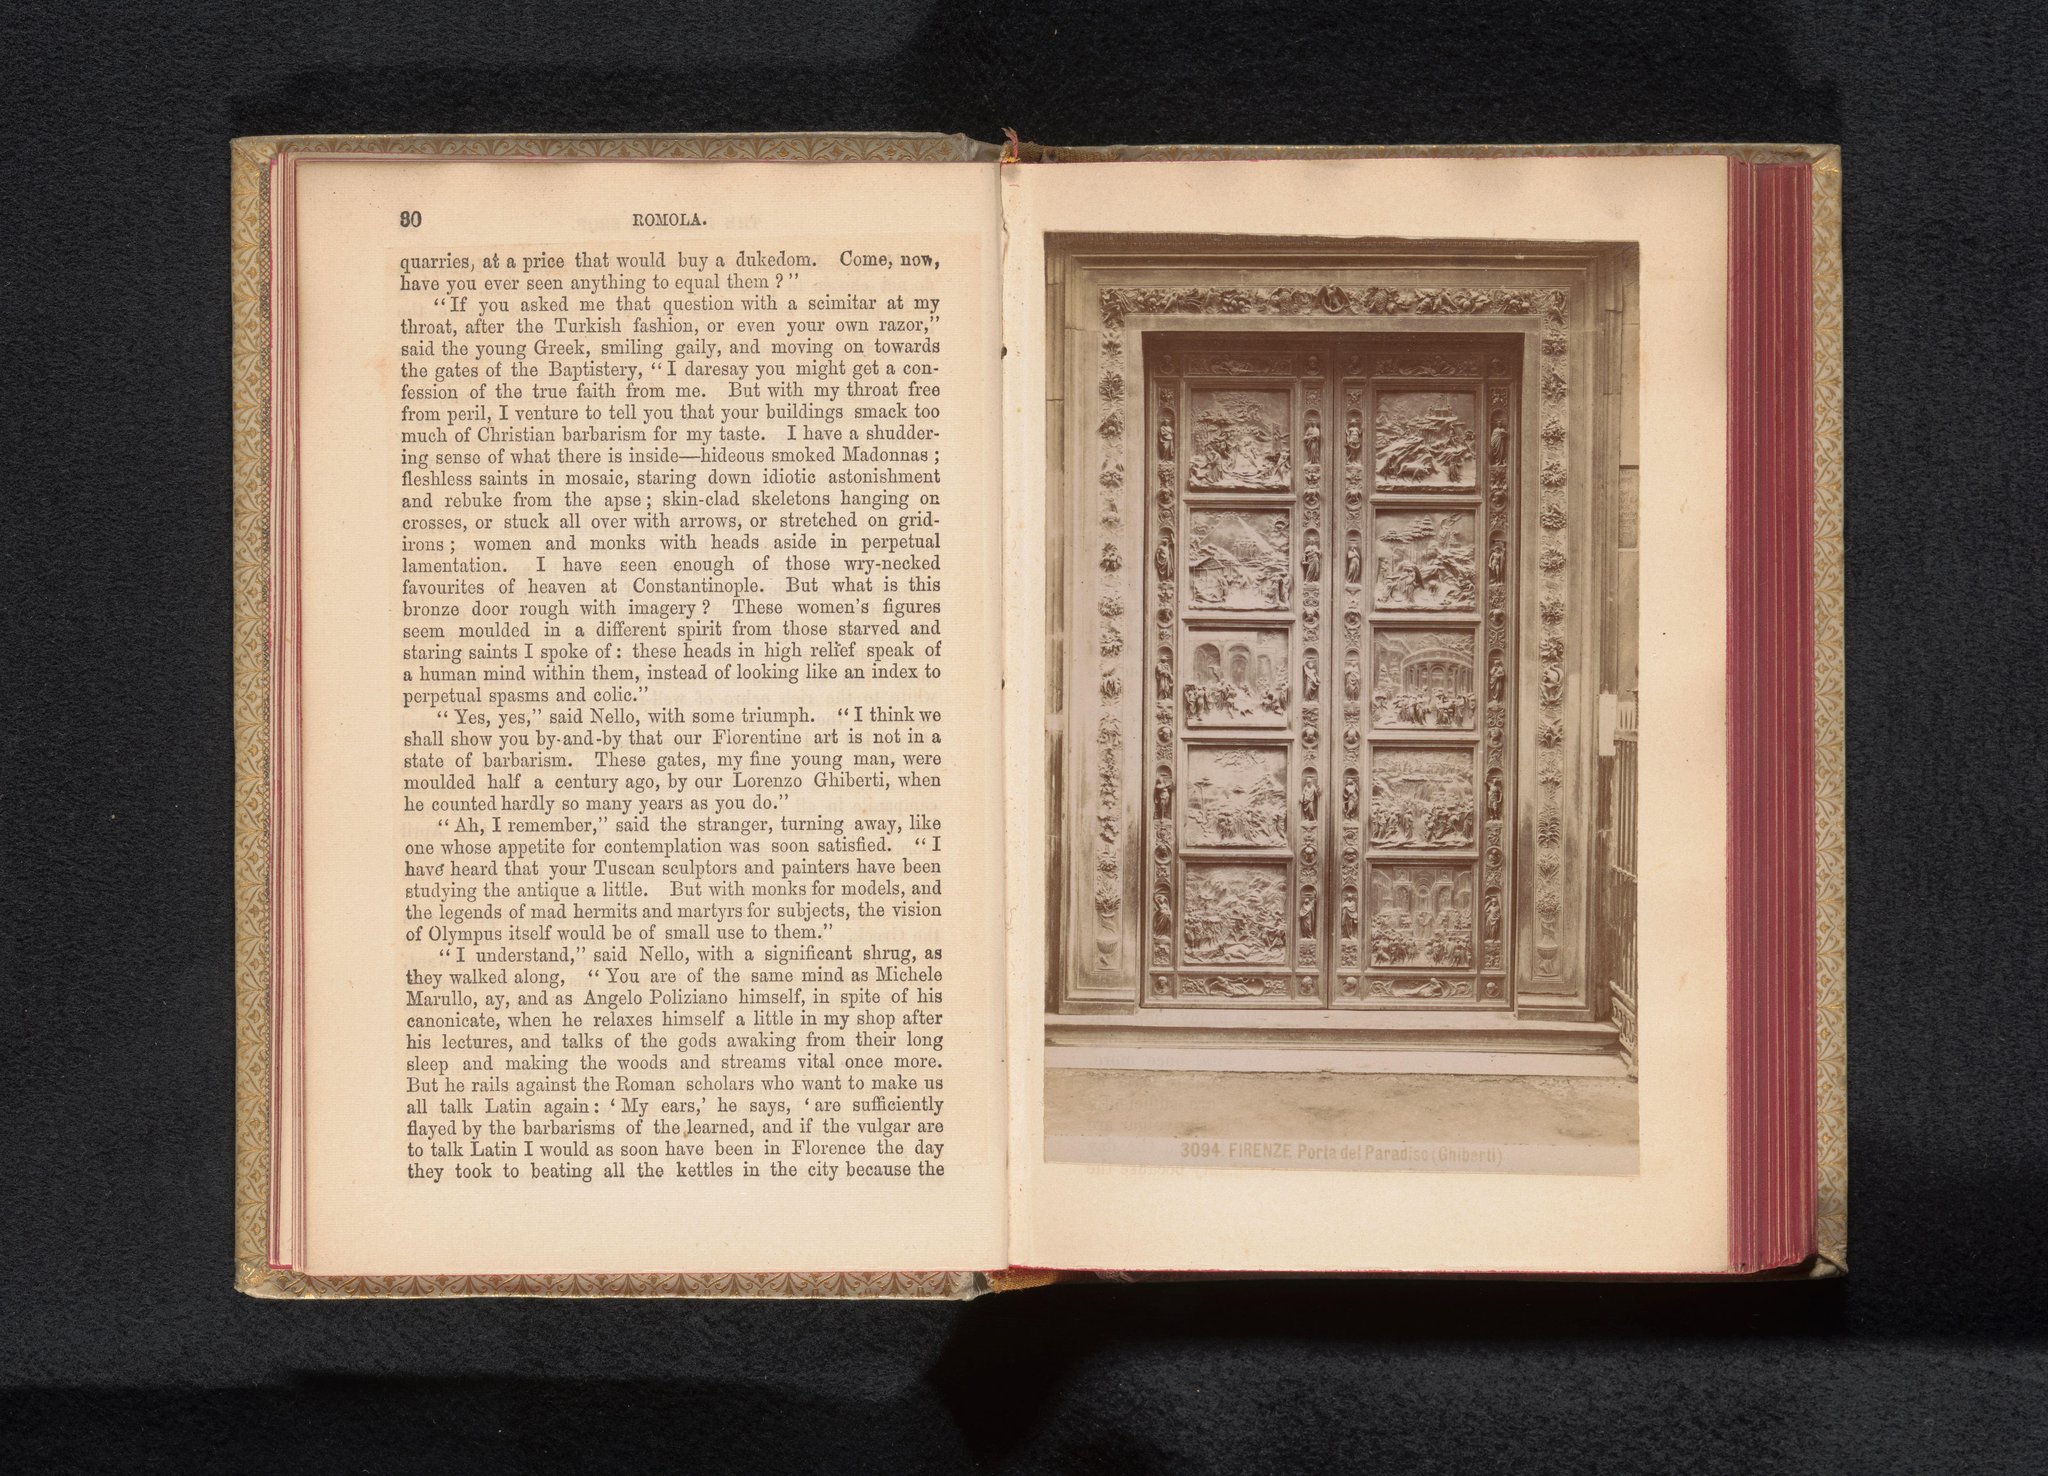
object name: page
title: Oostelijke deuren van het Baptisterium te Florence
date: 1878-1888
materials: photographic support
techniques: albumen print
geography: florence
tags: gate, entrance, sculpture (+ relief ~ sculpture)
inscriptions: number: ‘3094.’